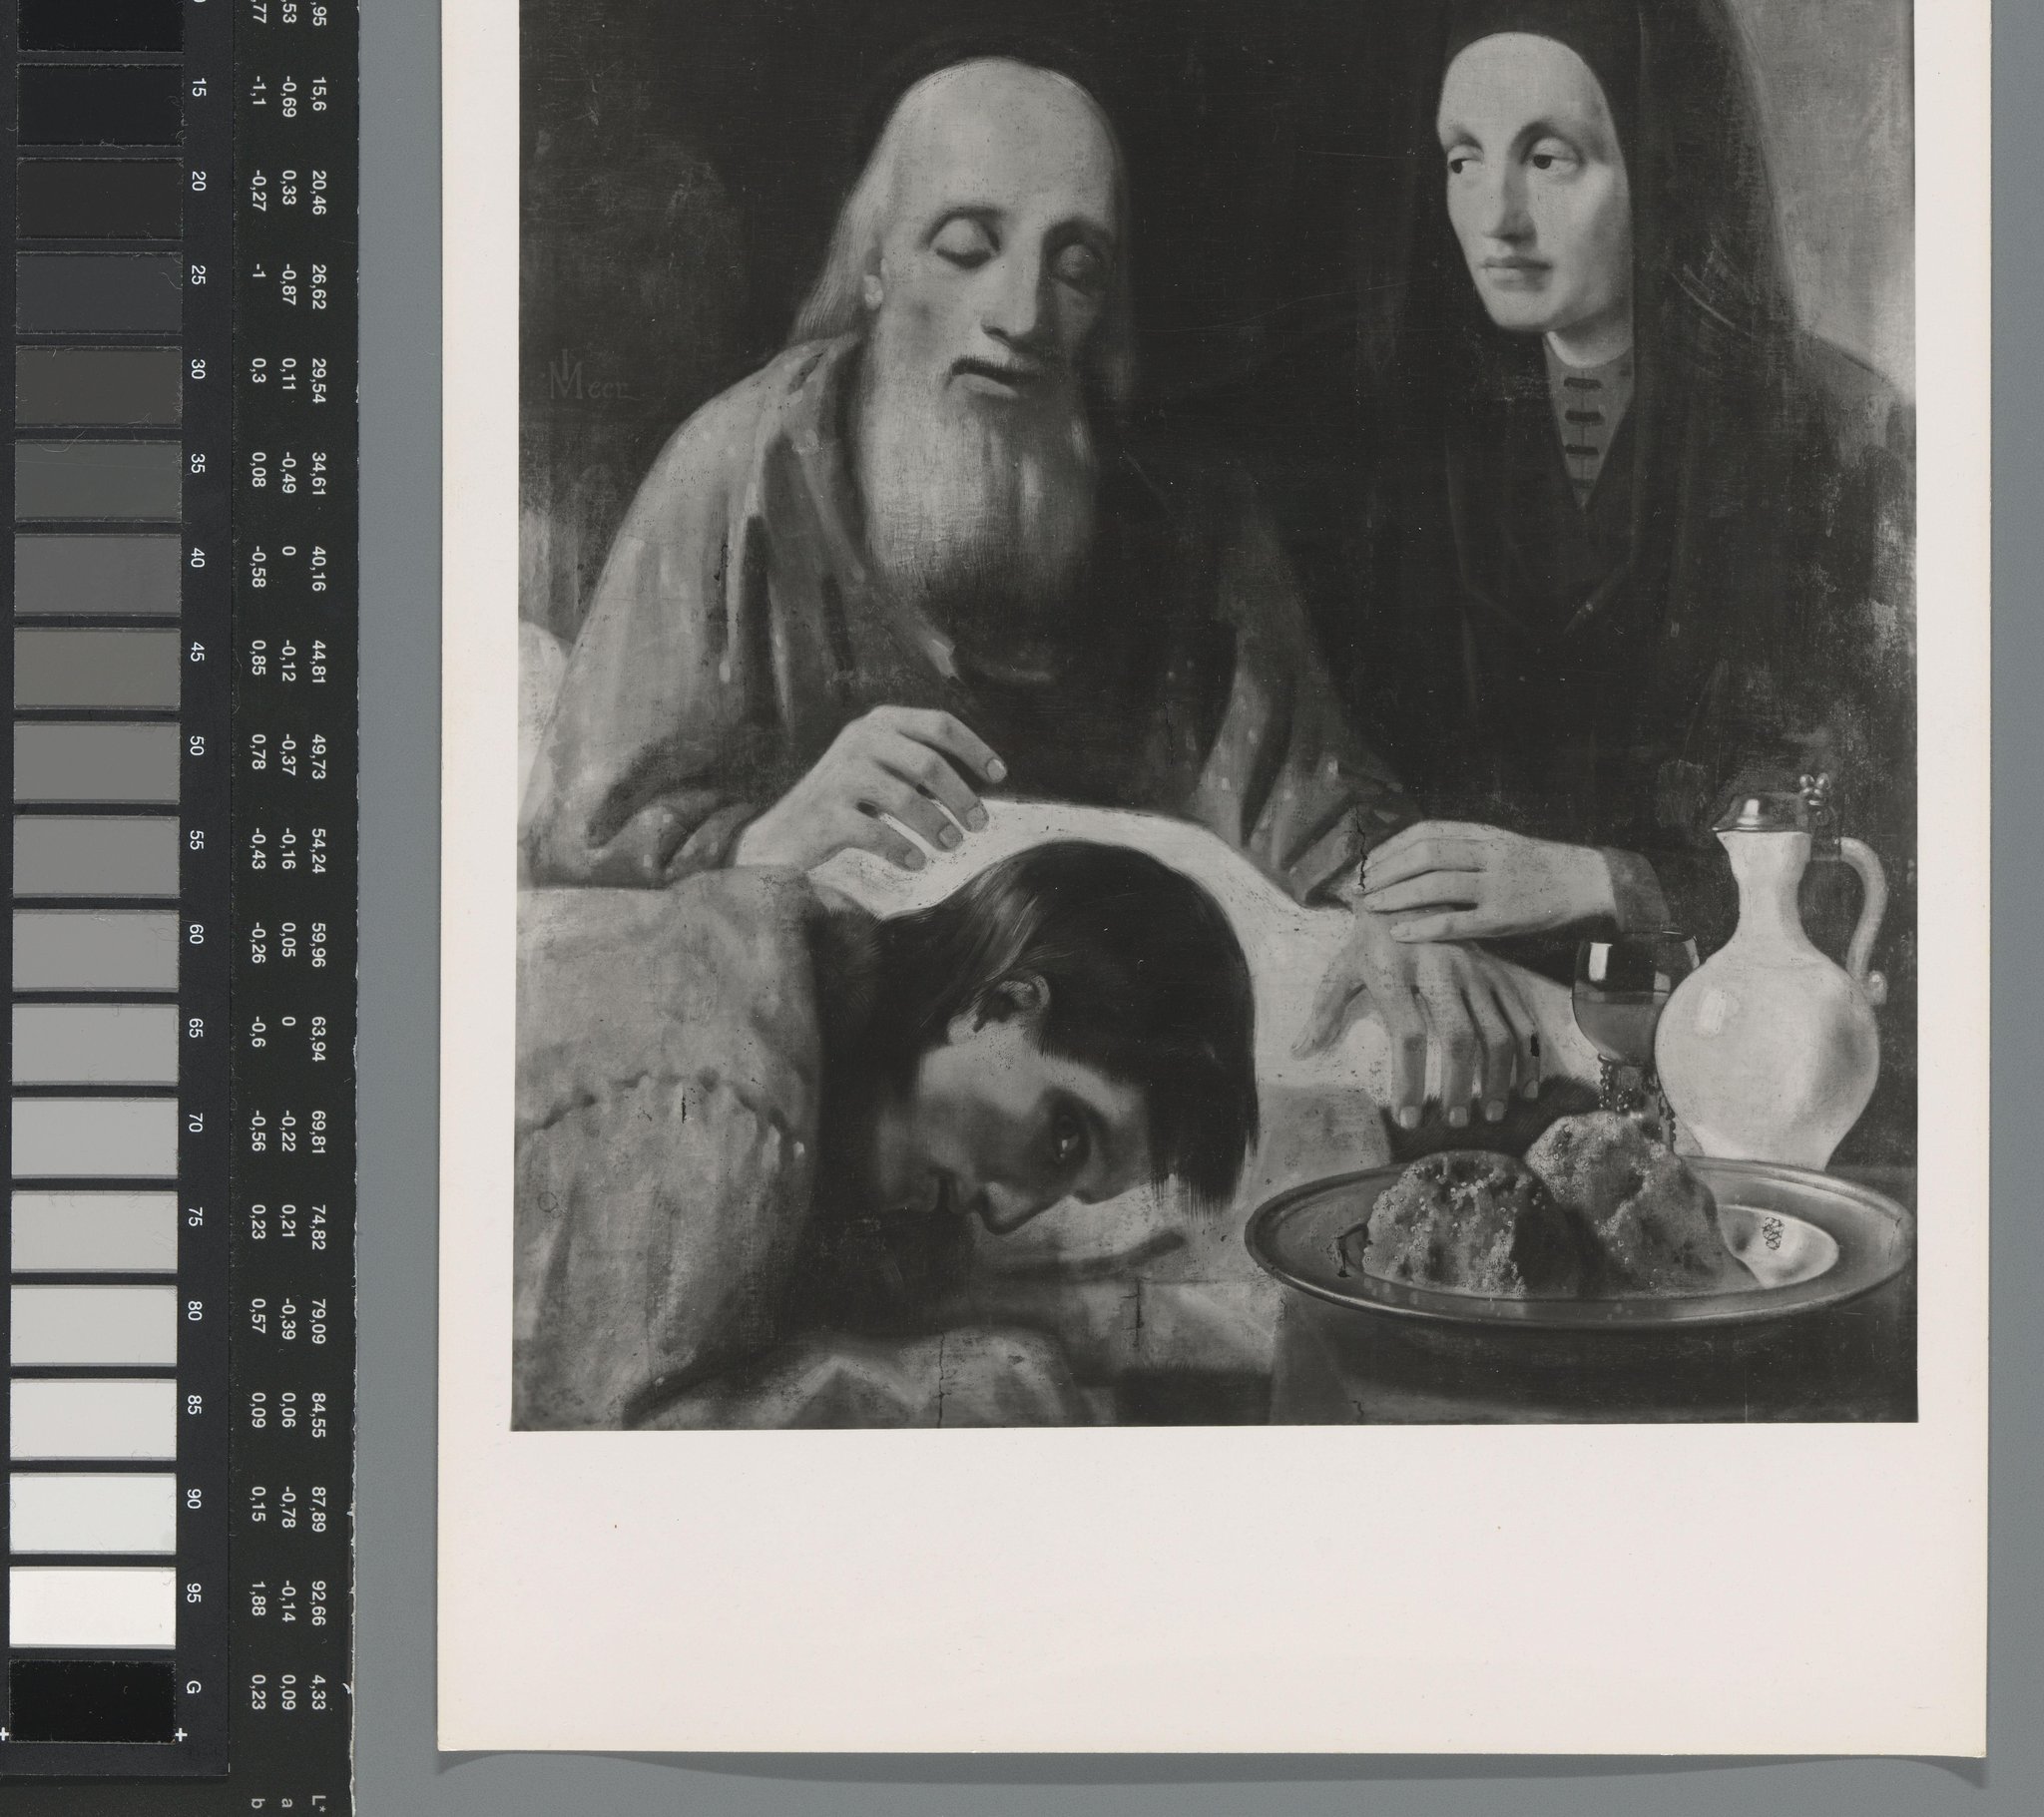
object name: photograph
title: Fotografische reproductie van een (detail) schilderij van Han van Meegeren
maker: nico zomer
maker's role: fotograaf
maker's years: 1910-1988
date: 1908-1948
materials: photographic support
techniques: gelatin silver print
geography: amsterdam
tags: picture, painting